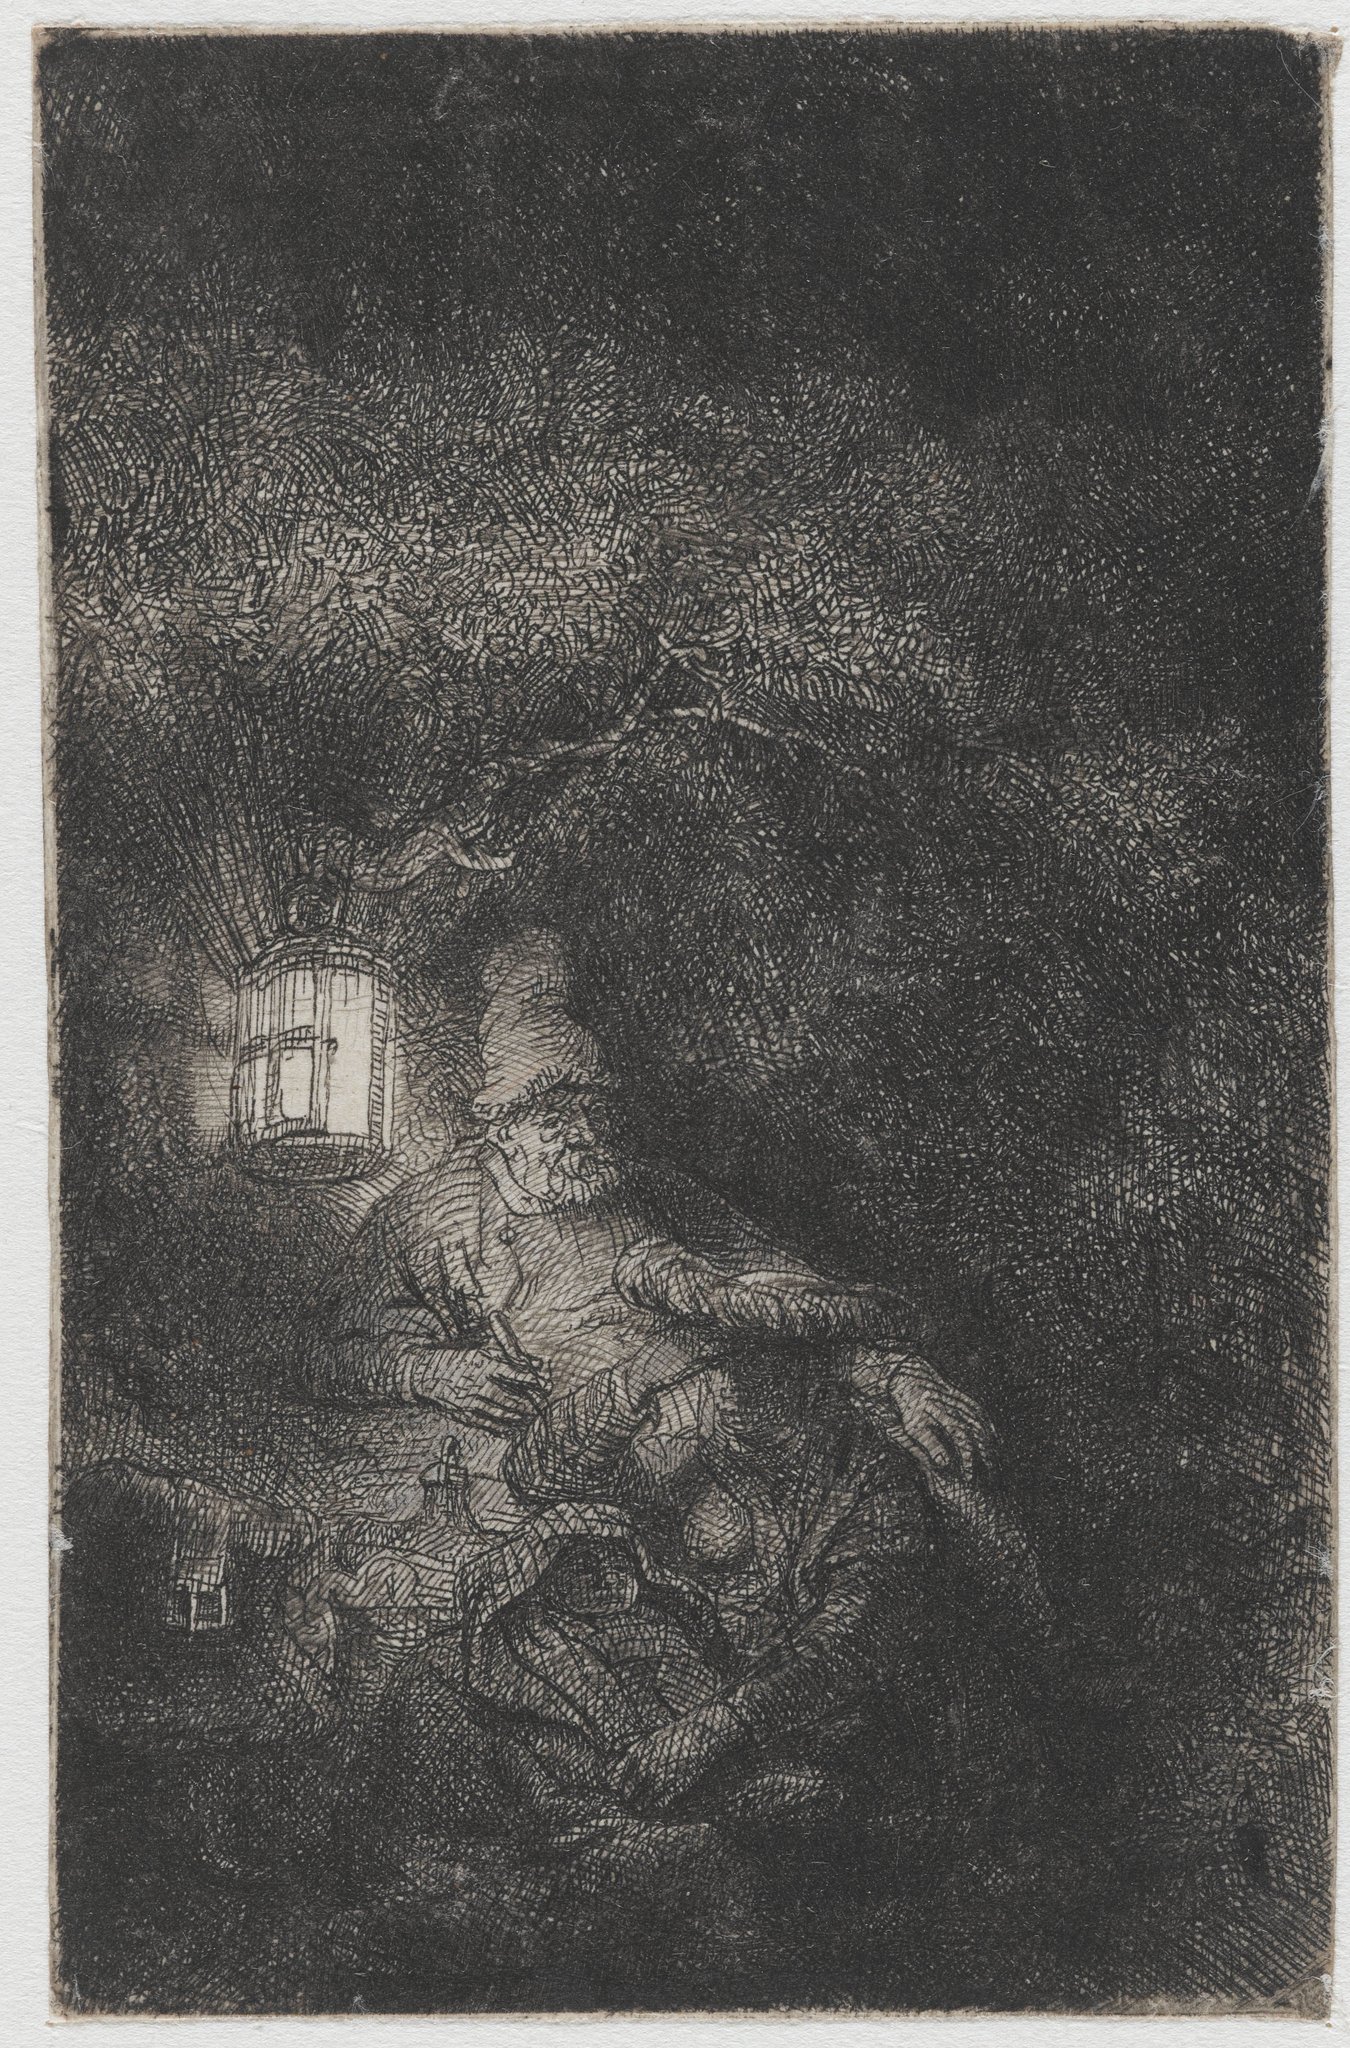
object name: print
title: The rest on the flight into Egypt: a night piece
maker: rembrandt van rijn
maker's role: draughtsman, painter, print maker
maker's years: 1606-1669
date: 1644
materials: paper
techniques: drypoint, etching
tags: rest on the flight into egypt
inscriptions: inscription: ‘W.S. .1772. no. 10.’, mark: Lugt 439, mark: Lugt 2228